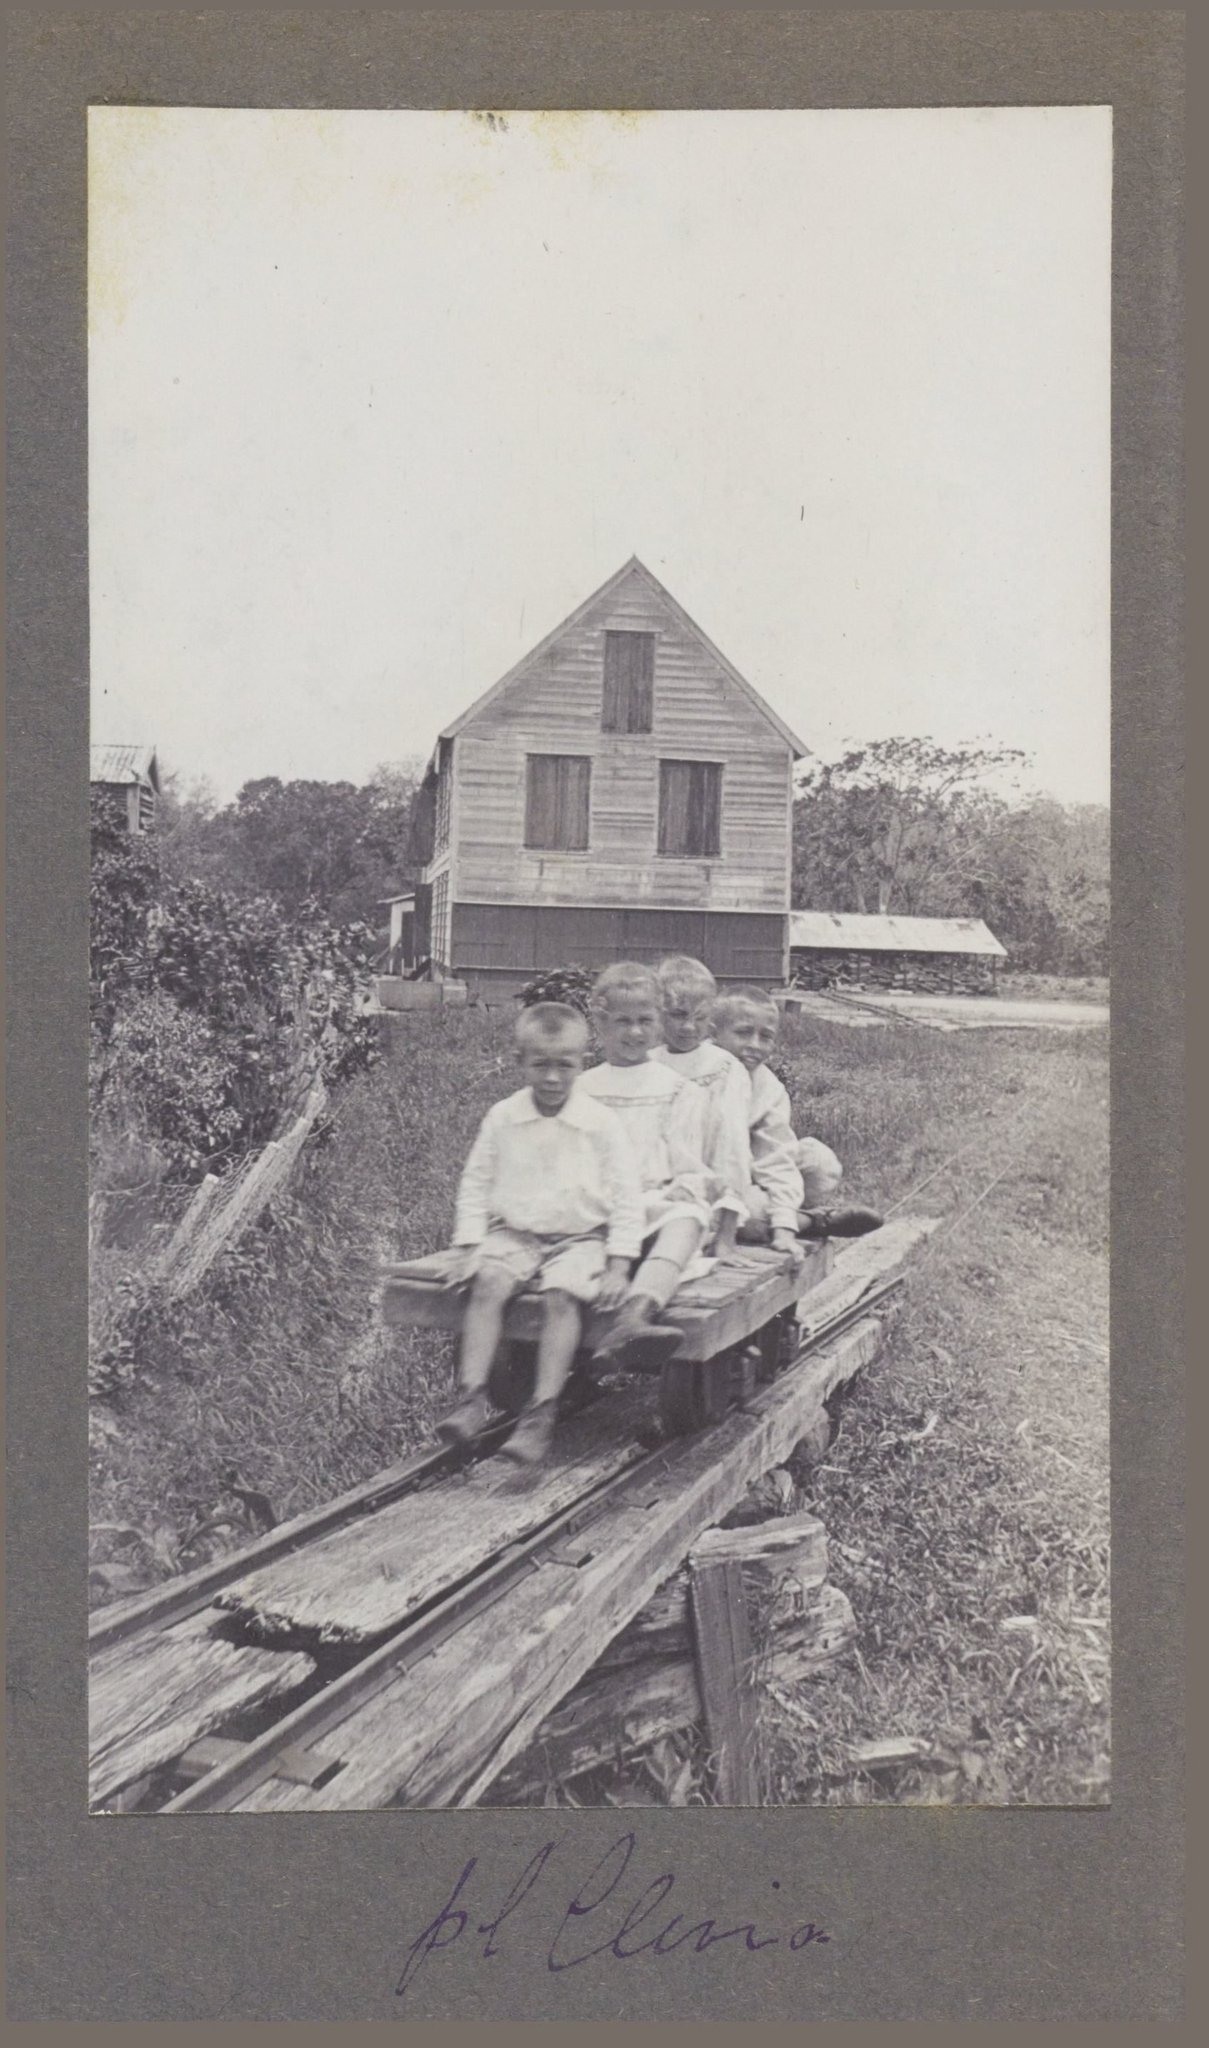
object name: photograph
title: Kinderen op Plantage Clevia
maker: Anonymous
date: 1912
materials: photographic support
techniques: photography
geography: suriname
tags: suriname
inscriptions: inscription: ‘pl Clevia’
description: Vier kinderen spelend op een treinbaantje op Plantage Clevia. Onderdeel van het fotoalbum over het leven van de familie Gonggrijp in Suriname rond 1912.